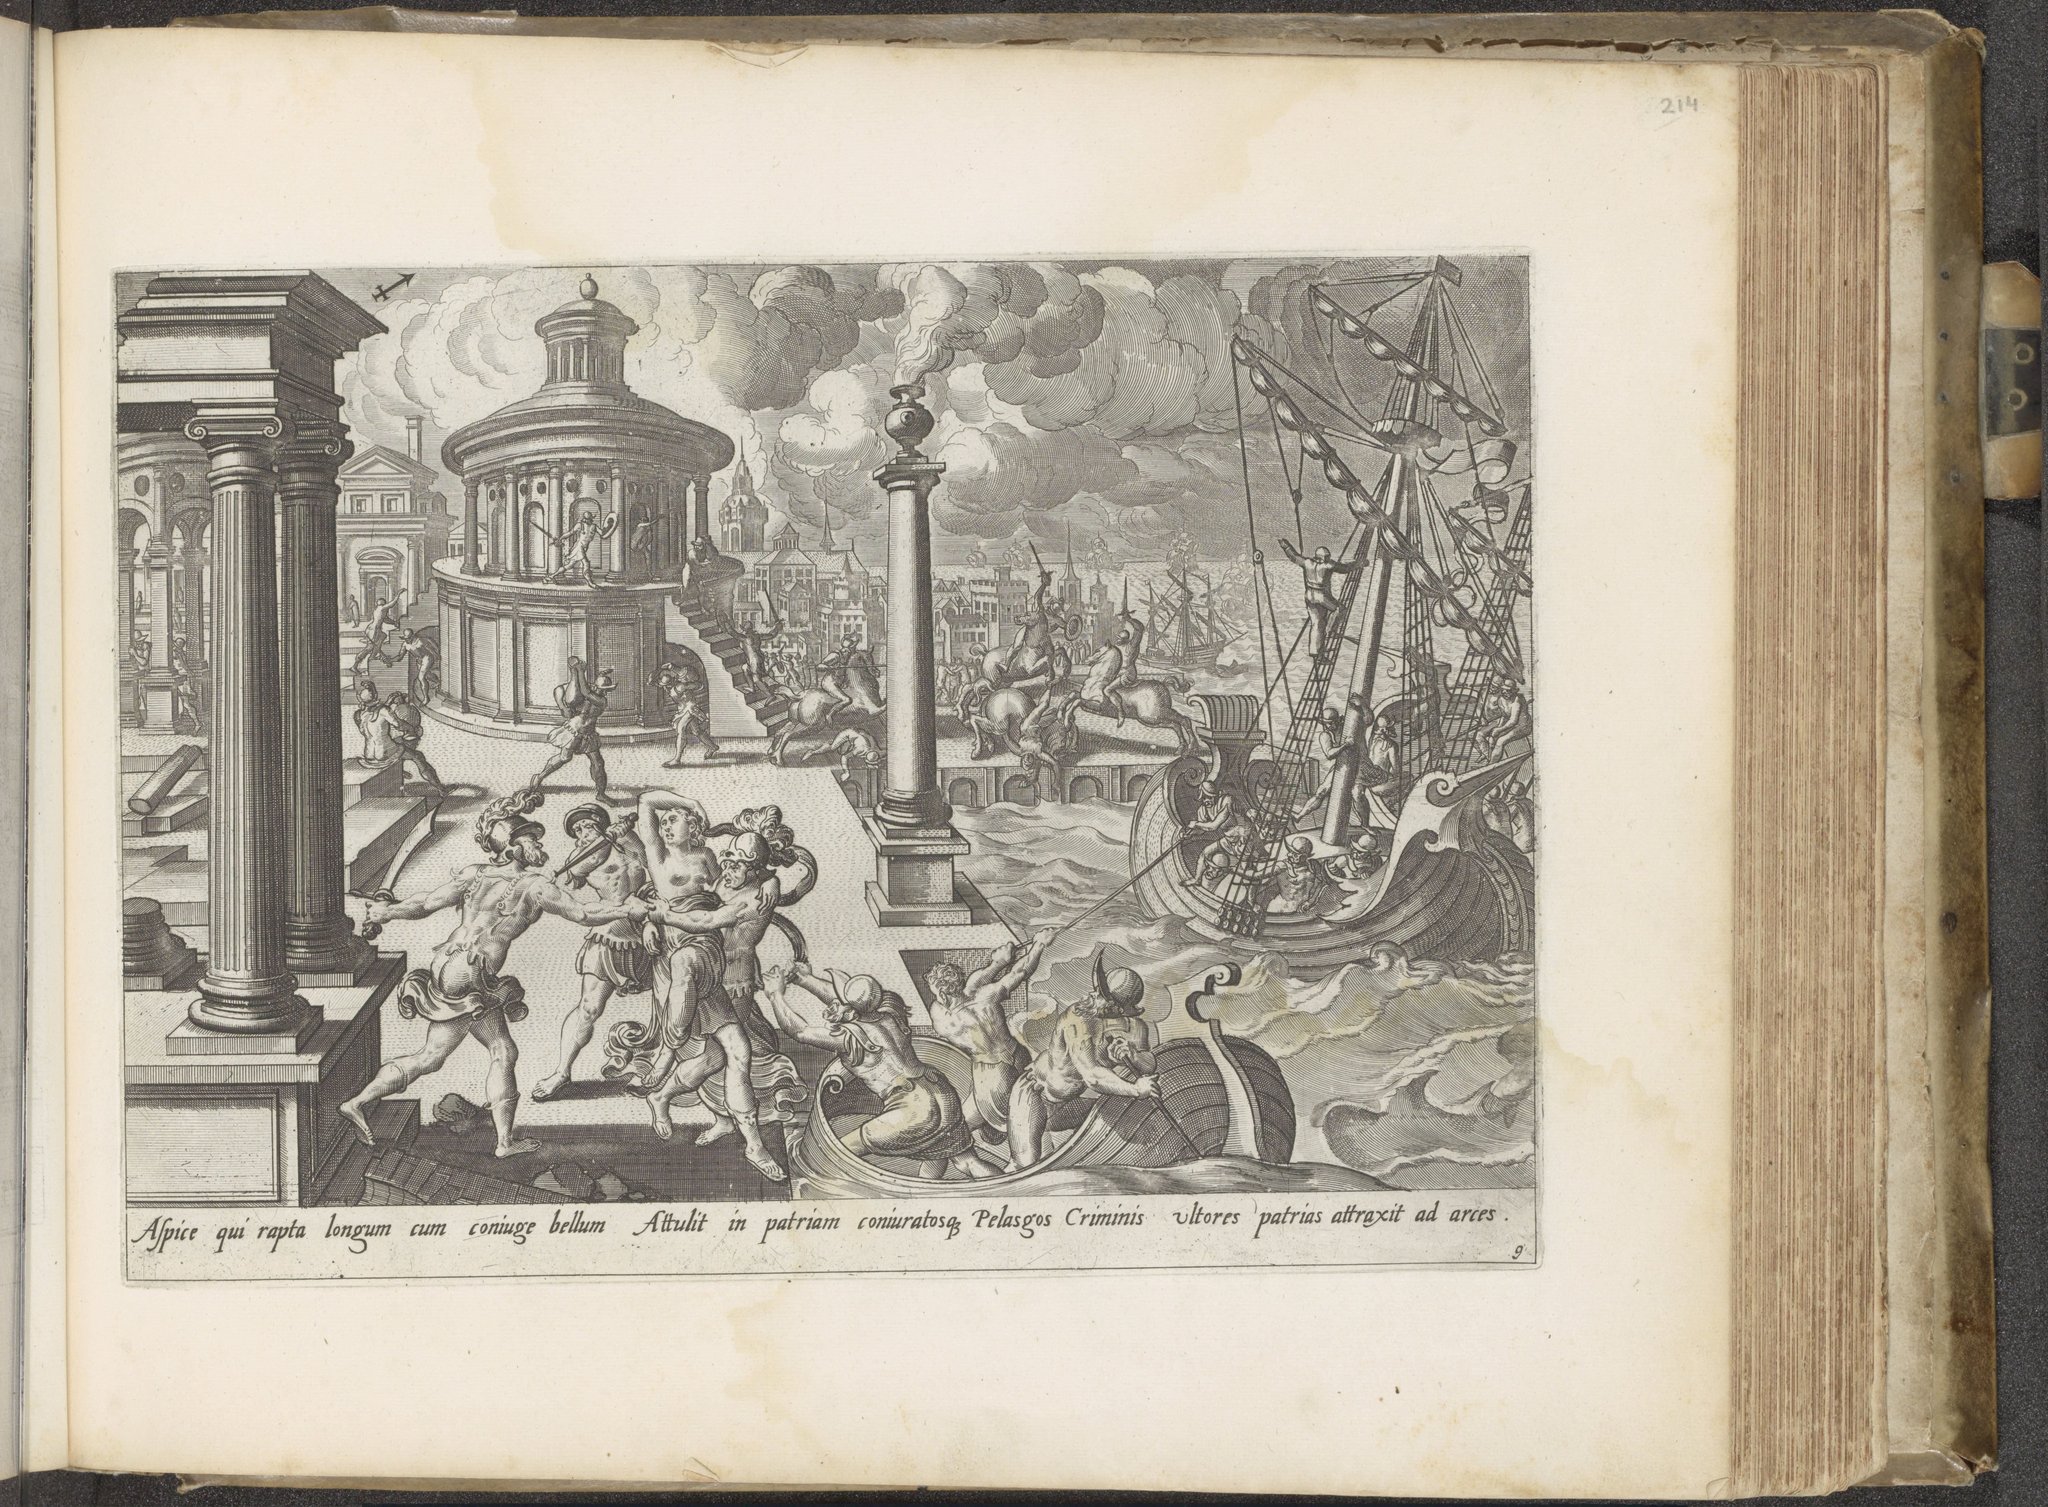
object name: print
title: Roof van Helena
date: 1653-1654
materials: paper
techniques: etching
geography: amsterdam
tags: (story of) hecuba, the abduction of helen and some of her companions: paris carries them off by sea, and takes a part of the palace-treasure with him, sagittarius (zodiacal sign of november)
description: Haven met de roof van Helena. Helena wordt door twee mannen naar een boot gevoerd. Onder de voorstelling de tekst uit de Metamorfosen van Ovidius, boek 12, versregels 5-6. Bovenaan het teken van de Boogschutter uit de dierenriem. De prent maakt deel uit van een album. De toelichting bij de prent op een ander albumblad beschrijft deze voorstelling als Hekabe en de val van Troje.